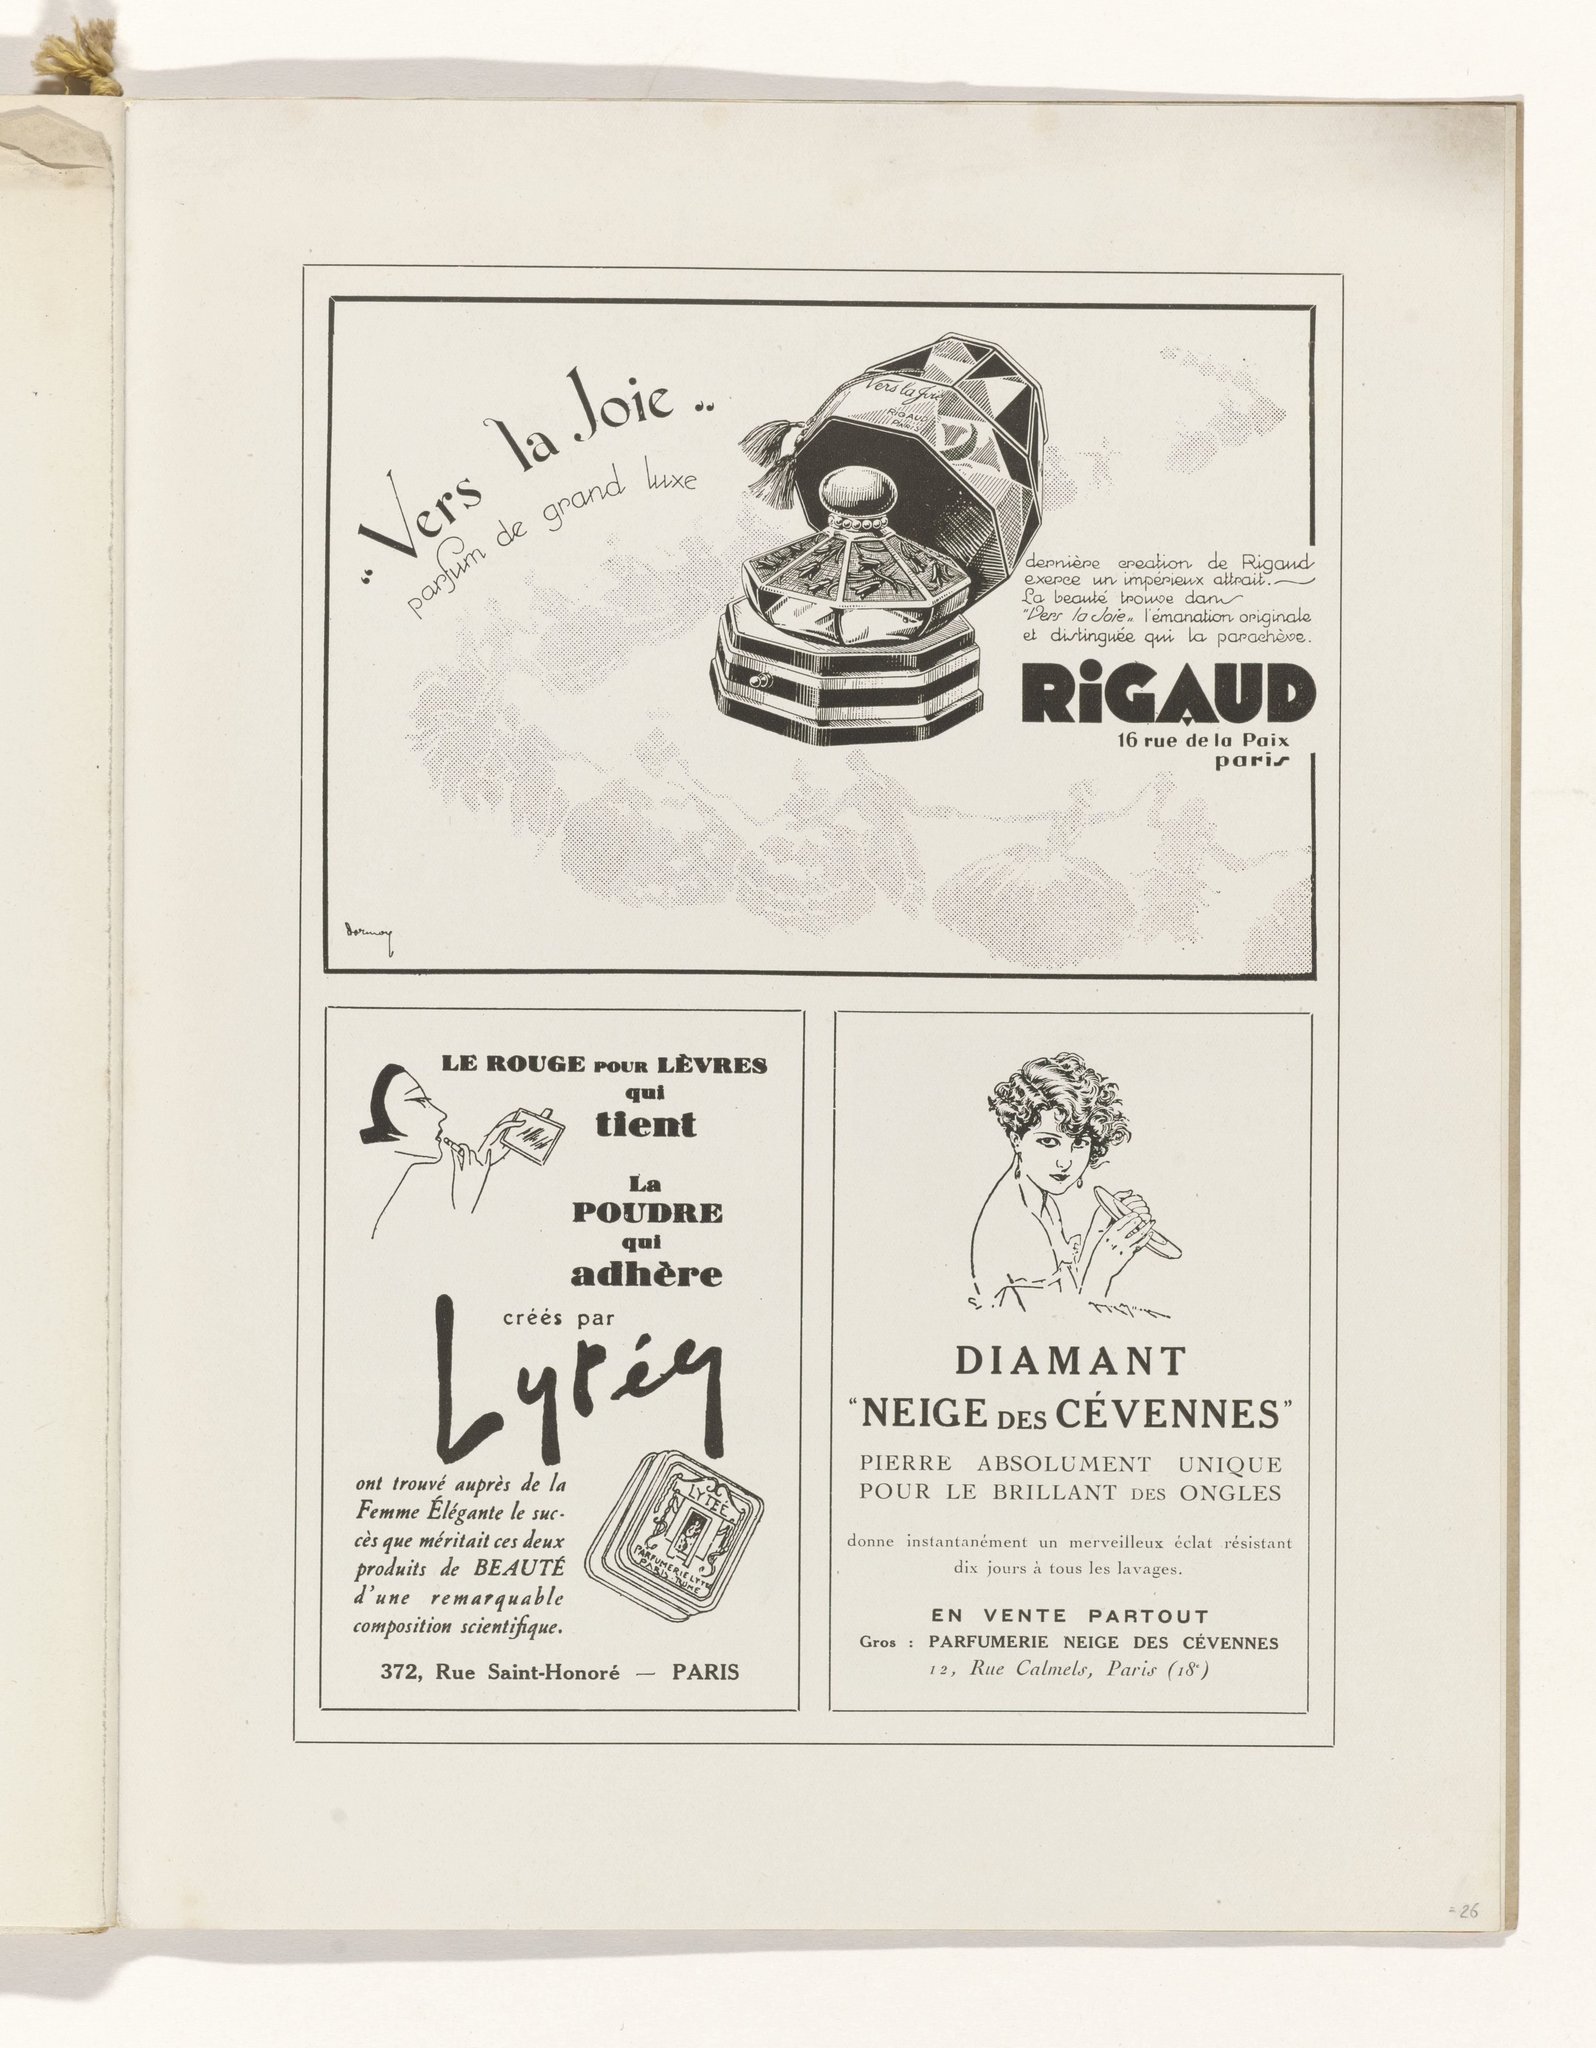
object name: magazine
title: Art - Goût - Beauté, Feuillets de l' élégance féminine, Juin 1929, No. 106, 9e Année, p.26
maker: charles goy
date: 1929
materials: paper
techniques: photography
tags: perfume bottle - aa - (for) women, fashion plates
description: Drie advertenties voor verschillende producten. Pagina uit het modetijdschrift Art-Goût-Beauté (1920-1933).